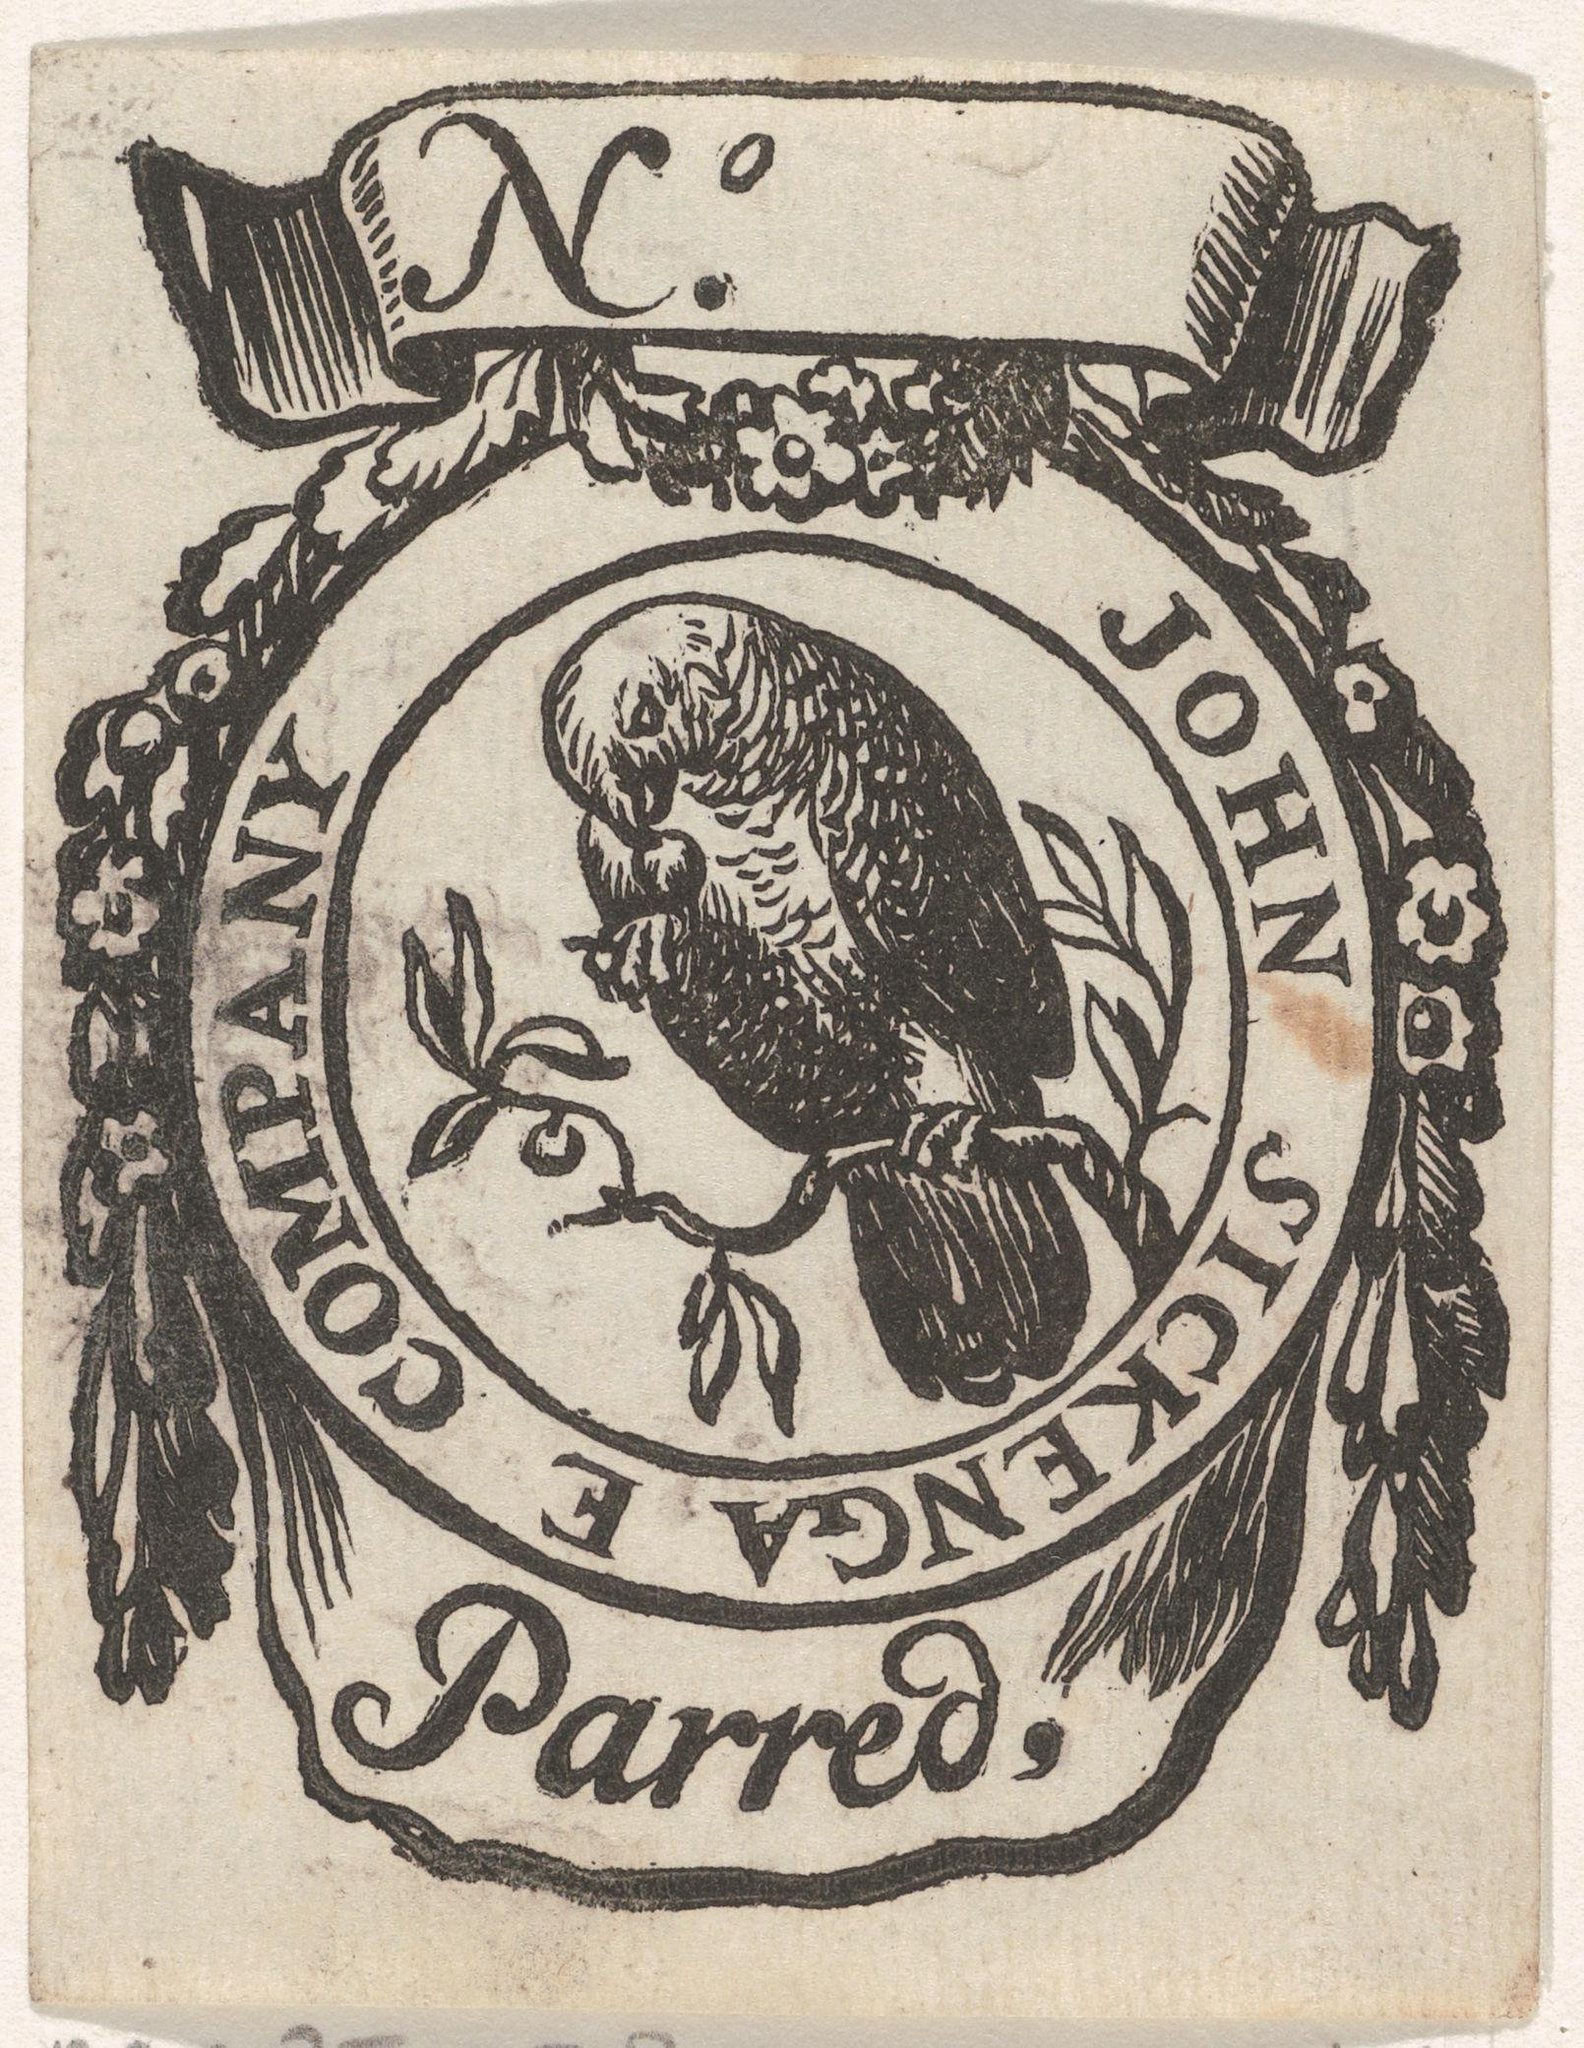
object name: handelsetiket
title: Parred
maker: isaac vincentsz. van der vinne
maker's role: draughtsman, print maker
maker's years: 1665-1740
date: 1681-1740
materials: paper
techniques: woodcut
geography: haarlem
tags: ornamental birds: parrot, vignette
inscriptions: collector's mark: Lugt 240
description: Een papegaai in een cirkel met randschrift.